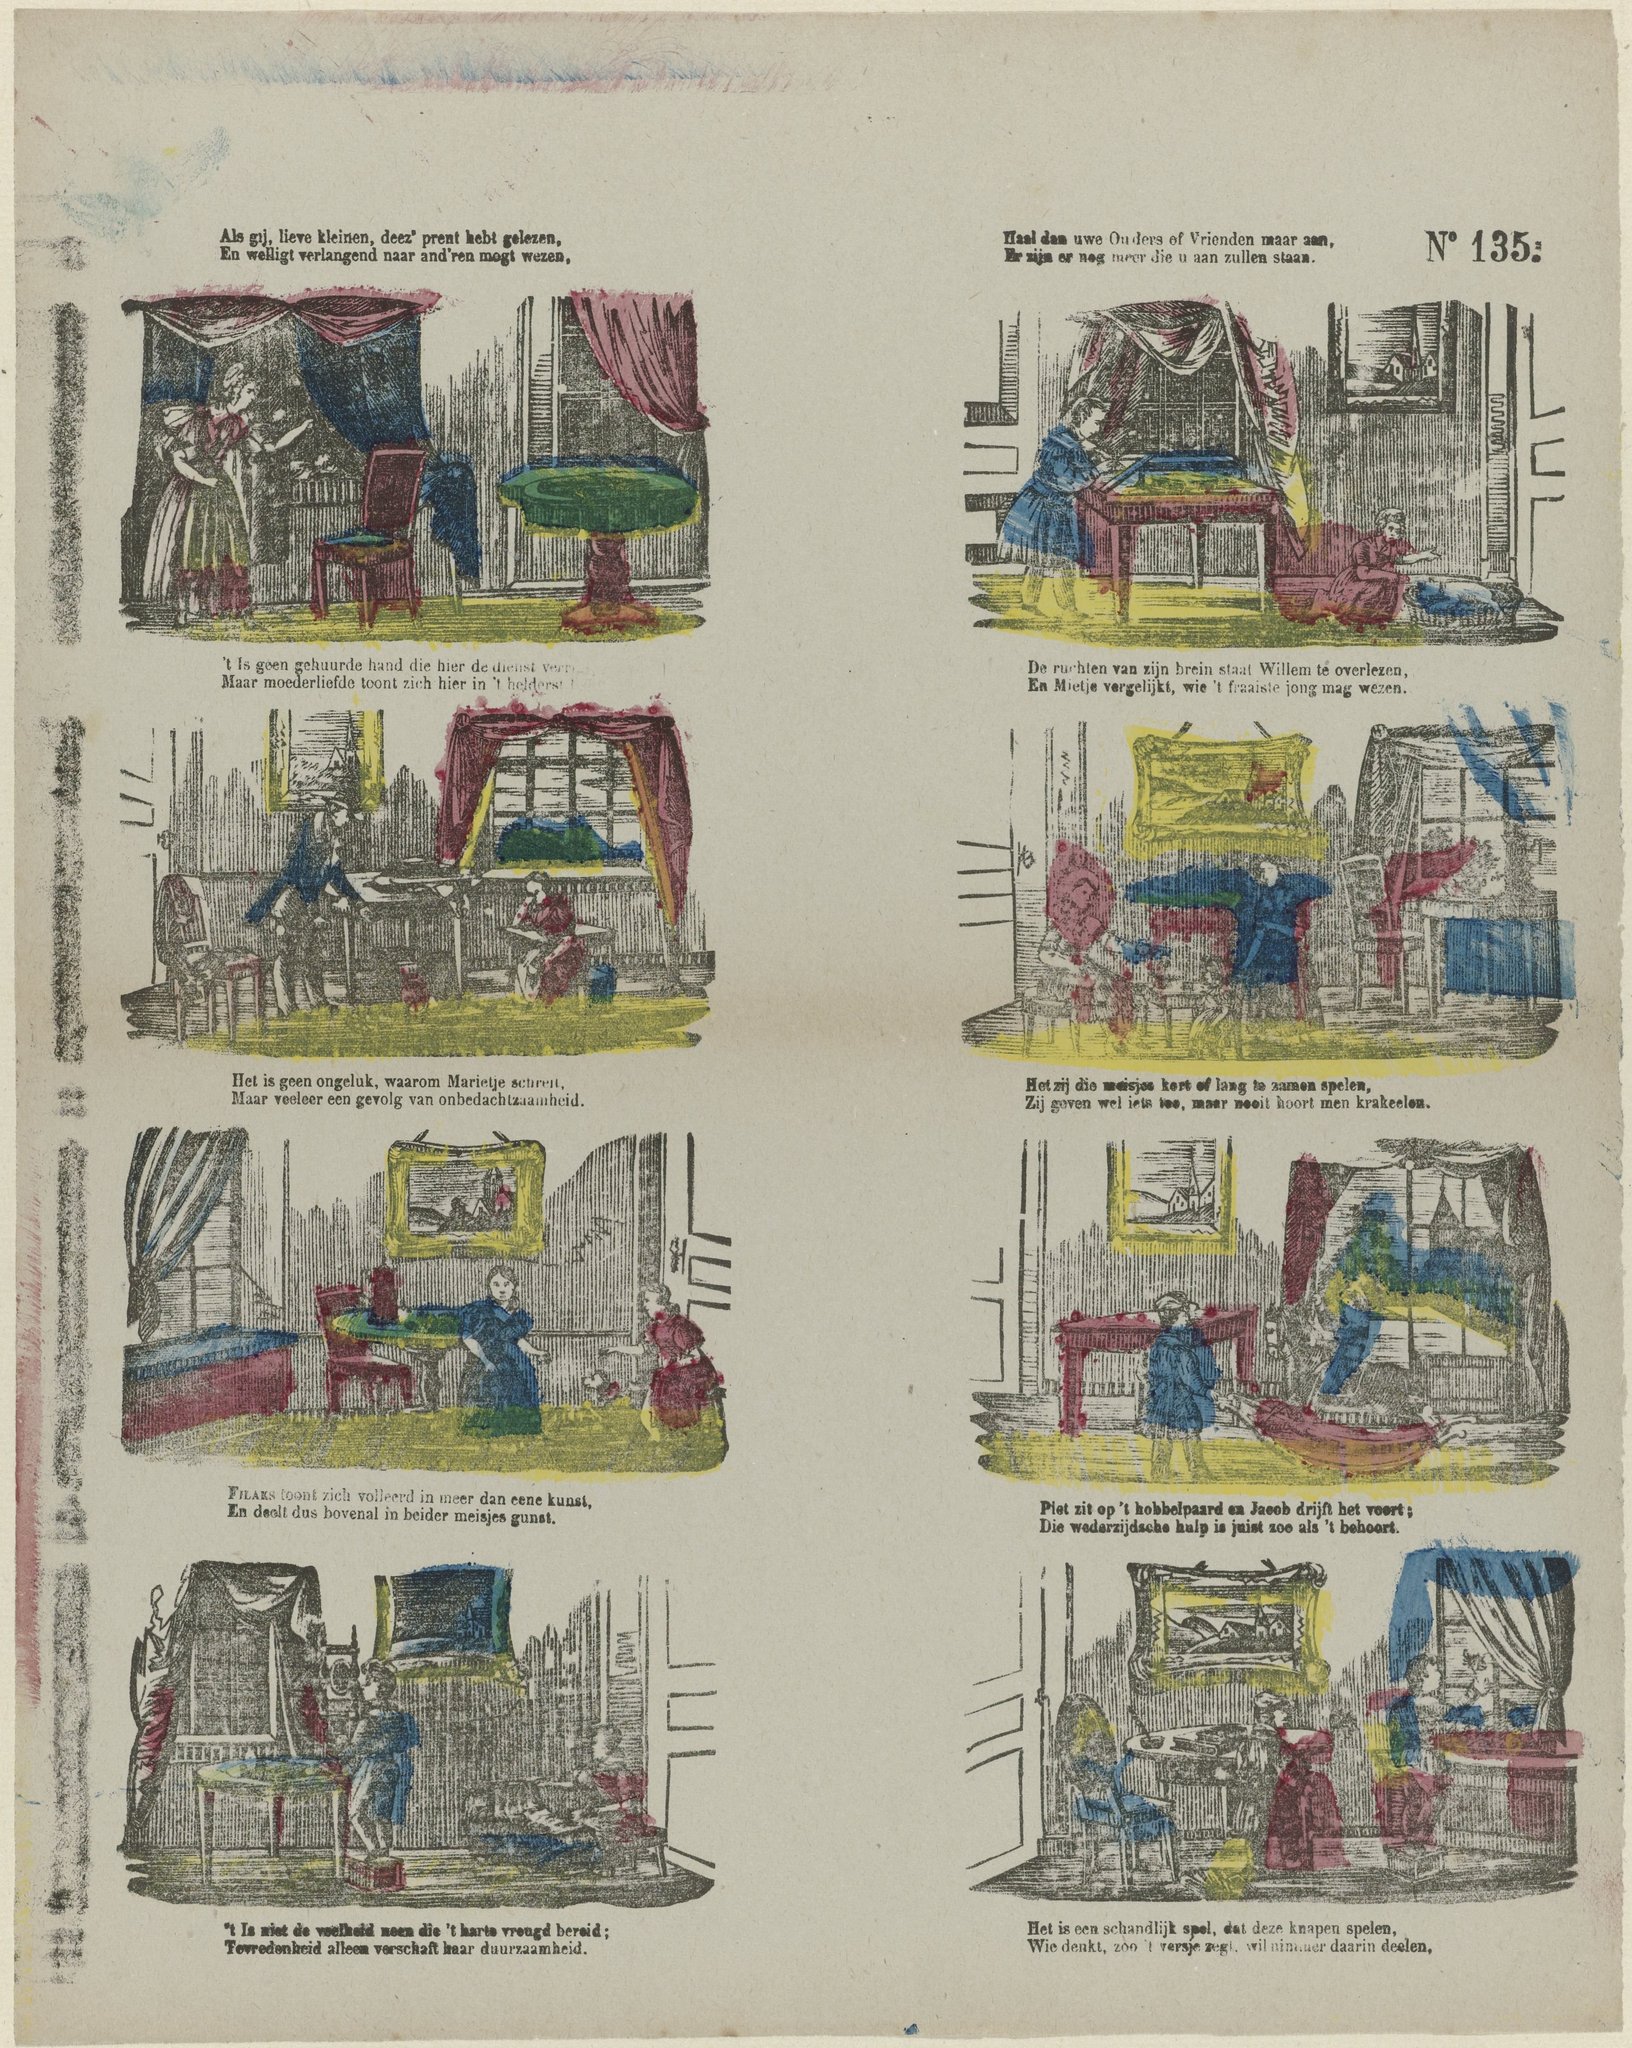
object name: popular print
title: Als gij, lieve kleinen, deez' prent hebt gelezen, / En welligt verlangend naar and'ren mogt wezen, / Haal dan uwe ouders of vriendenmaar aan, / Er zijn er nog meer die u aan zullen staan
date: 1827-1894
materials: paper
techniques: colour, letterpress printing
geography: schaarbeek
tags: education, science and learning, children's games and plays, child playing with animals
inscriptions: collector's mark: Lugt 2760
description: Blad met 8 voorstellingen van bezigheden voor kinderen, zoals studeren en spelen. Onder elke afbeelding een tweeregelig vers. Genummerd rechtsboven: No 135.